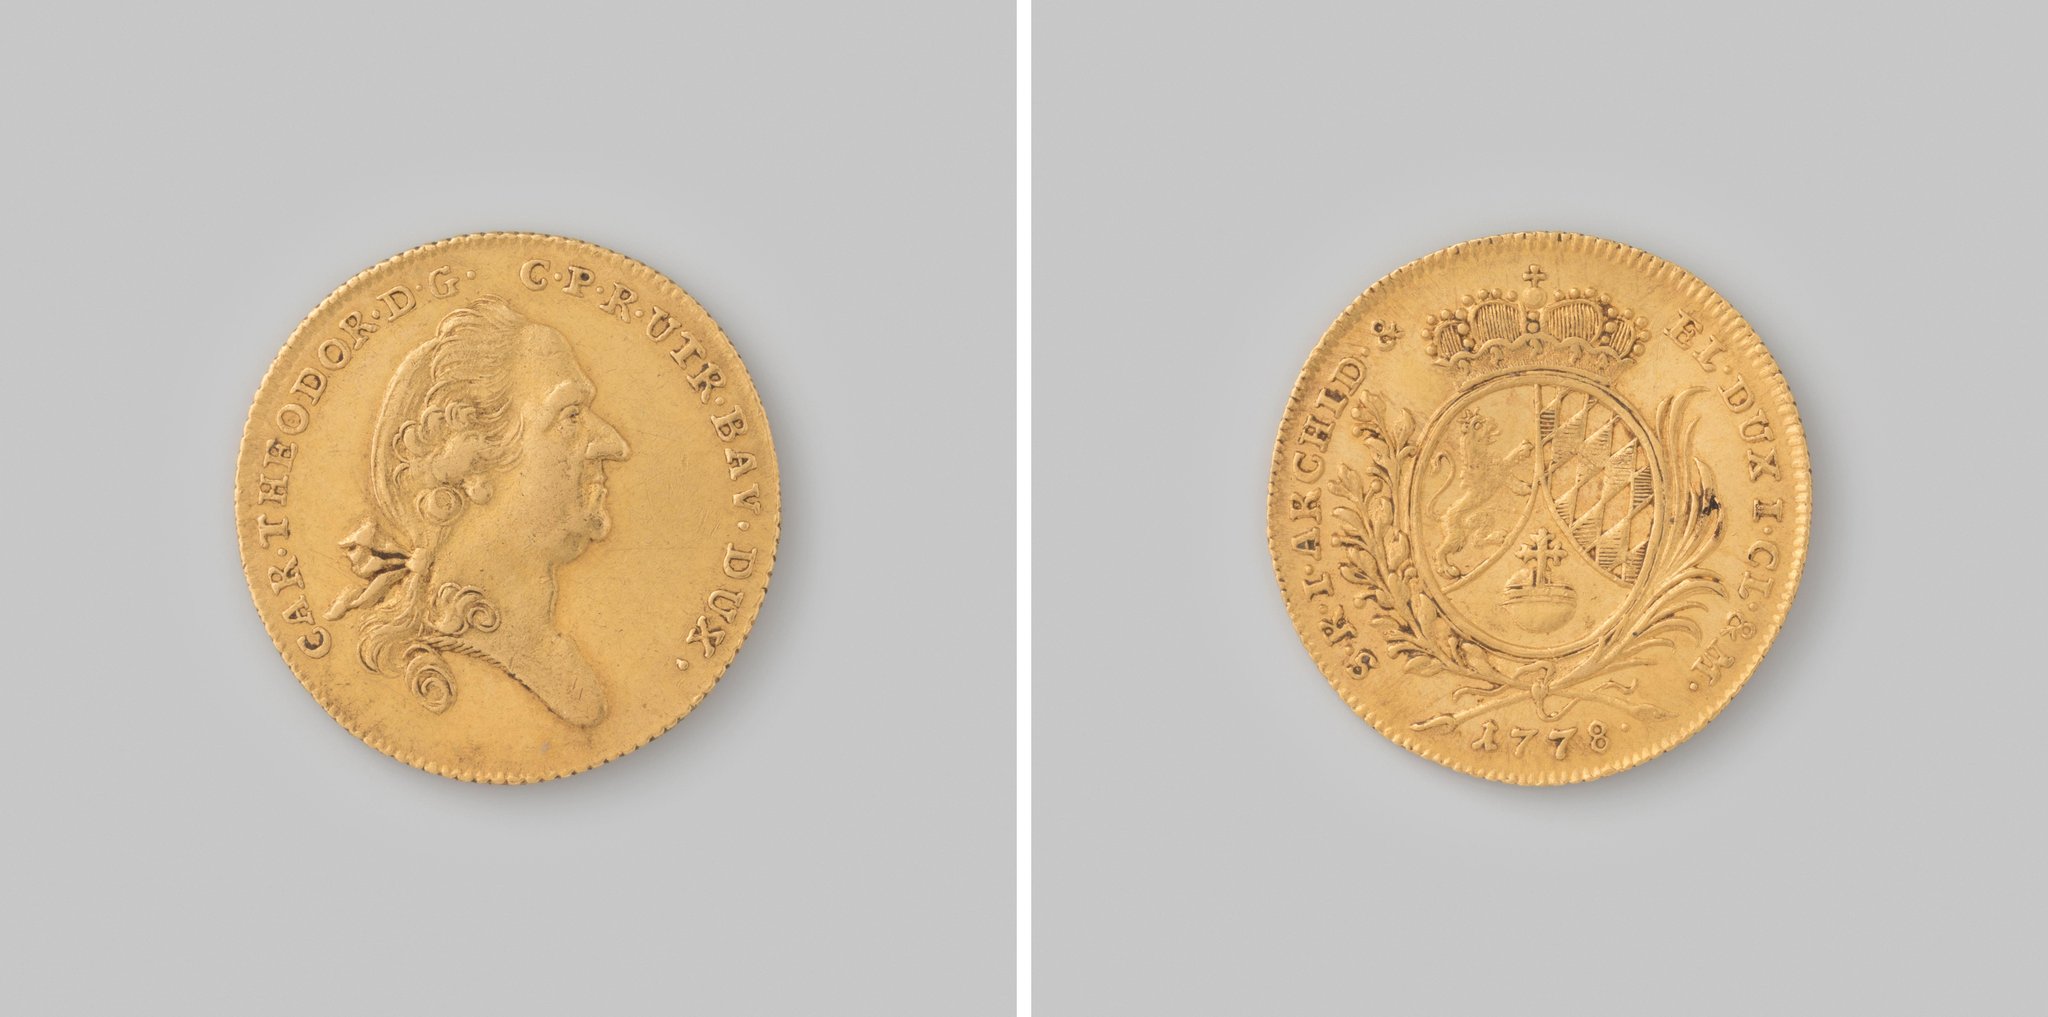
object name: ducat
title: Keurvorstendom Beieren, dukaat, keurvorst Karl Theodor, 1778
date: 1778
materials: gold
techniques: striking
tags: münchen, keurvorst, karel theodoor van beieren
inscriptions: circumscription: ‘S . R . I . ARCHID . & - EL . DUX . I . CL . & . M . / 1778 .’, circumscription: ‘CAR . THEODOR . D . G . - C . P . R . UTR . BAV . DUX .’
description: Gouden munt. Voorzijde: borstbeeld van de keurvorst naar rechts. Keerzijde: binnen twee samengebonden takken gekroond wapenschild. Jaartal onderaan in omschrift. Kabelrand.